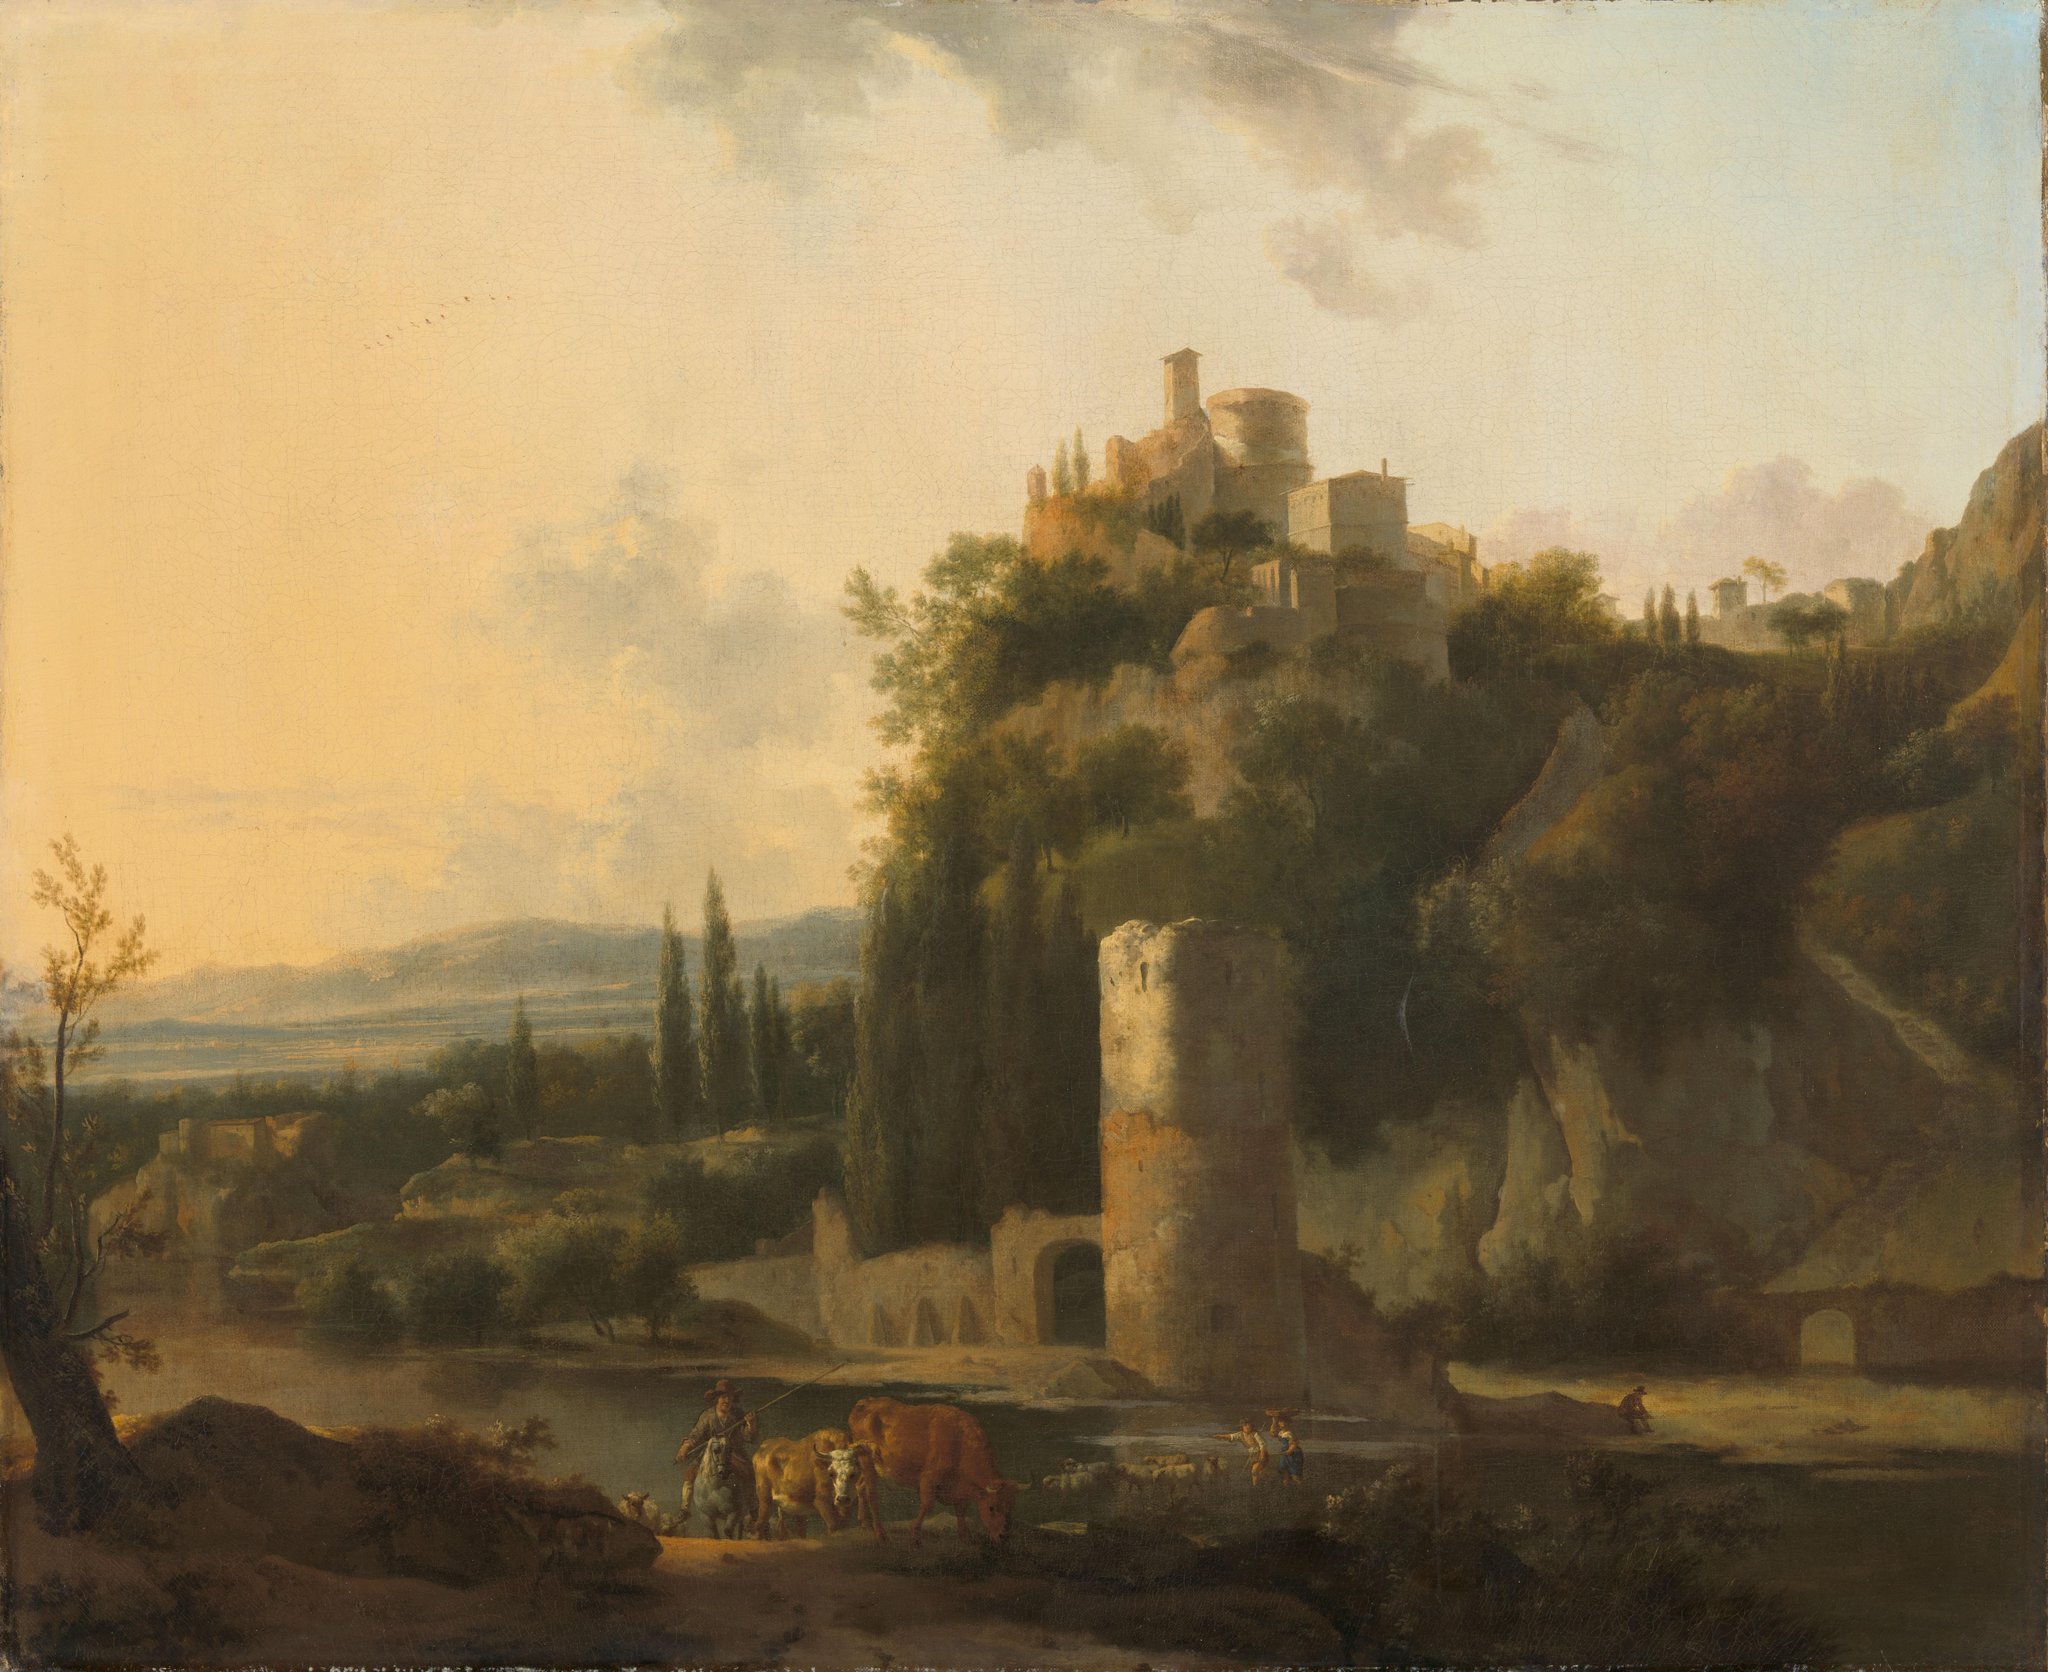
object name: painting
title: Italina landscape with round tower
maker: frederik de moucheron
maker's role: draughtsman, painter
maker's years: 1633-1686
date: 1667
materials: canvas, oil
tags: landscape with tower or castle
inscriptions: signature and date: ‘Moucheron fe 1667’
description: Italiaans landschap met een ronde toren bij een ruïne. Links een veedrijver een herders met vee bij de waterkant. Op de heuveltop staat een kasteel of klooster.